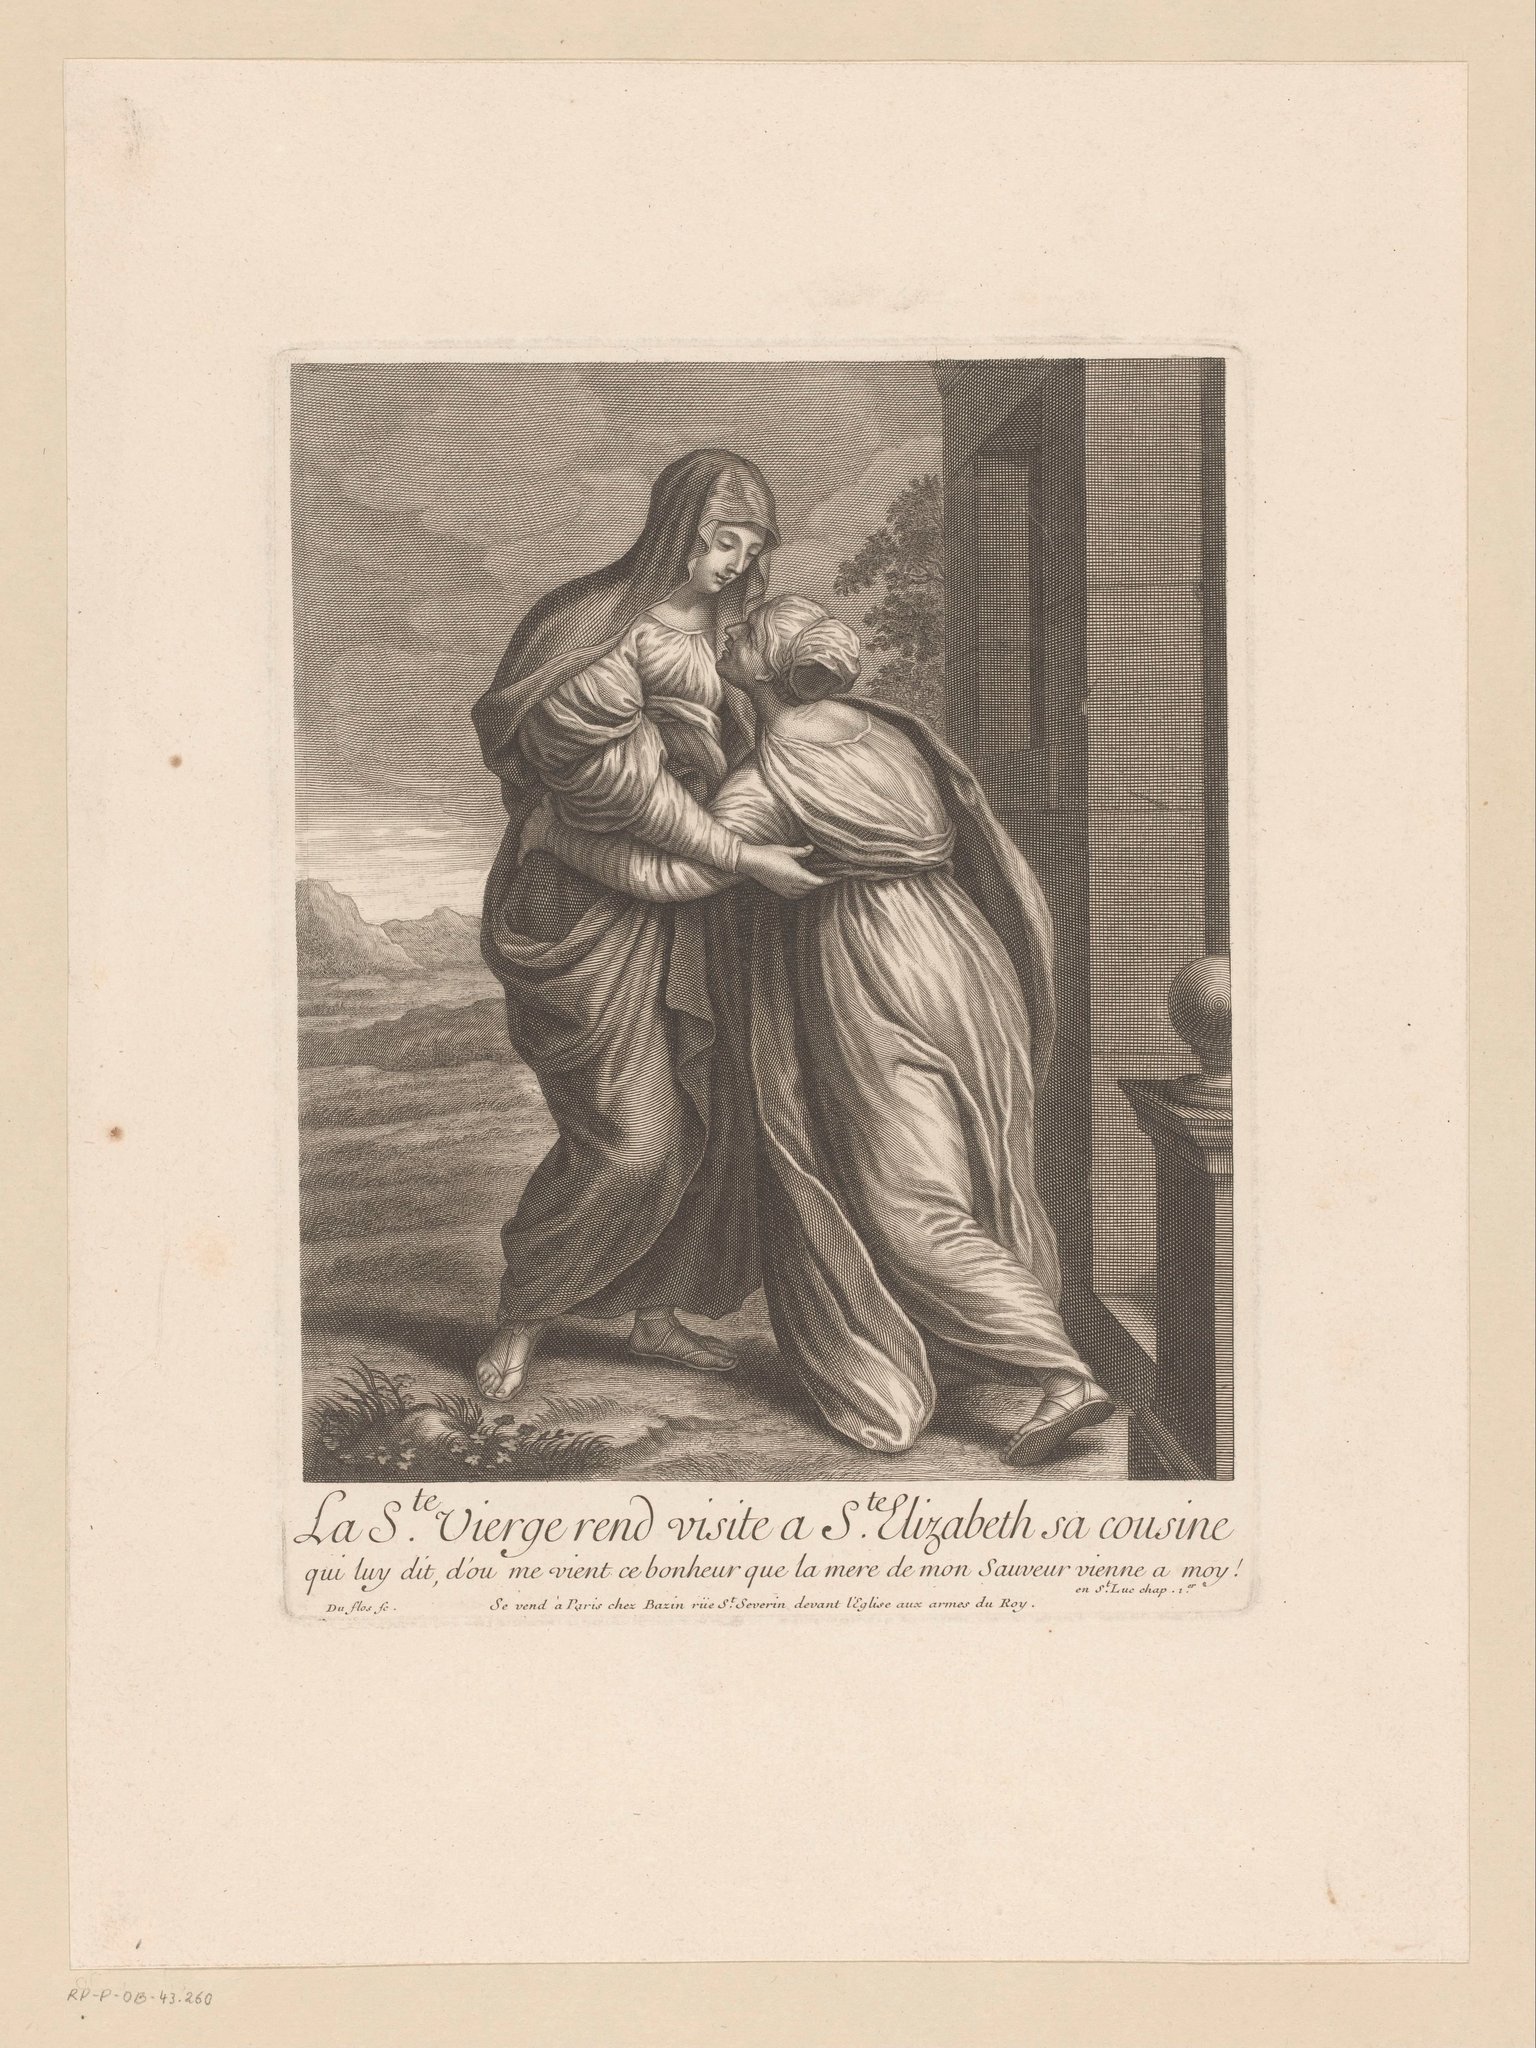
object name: print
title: La S.te Vierge rend visite a S.te Elizabeth sa cousine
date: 1675-1727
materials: paper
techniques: engraving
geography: paris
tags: visitation (possibly joseph and/or zacharias present) (luke 1:39-56)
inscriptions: collector's mark: Lugt 240